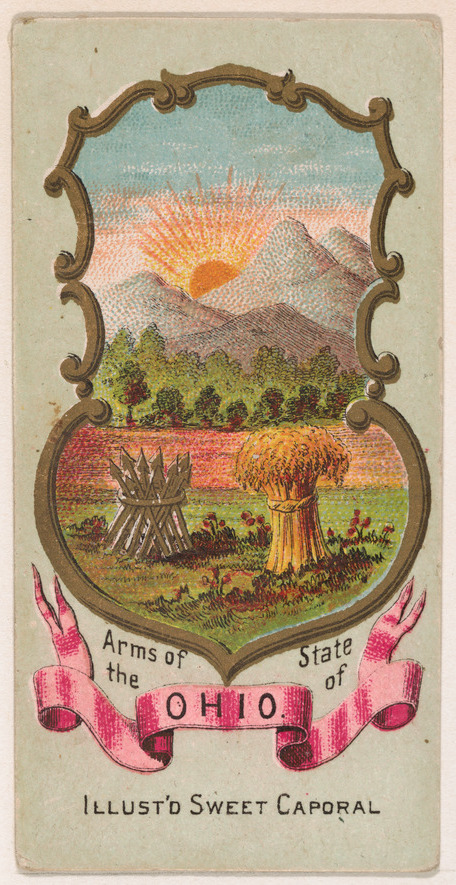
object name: print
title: Arms of the State of Ohio, from the Military Series (N224) issued by Kinney Tobacco Company to promote Sweet Caporal Cigarettes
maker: kinney brothers tobacco company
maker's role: publisher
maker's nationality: american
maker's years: 1869-2011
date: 1888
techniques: color lithograph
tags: sun,mountains,landscapes,trees,coat of arms